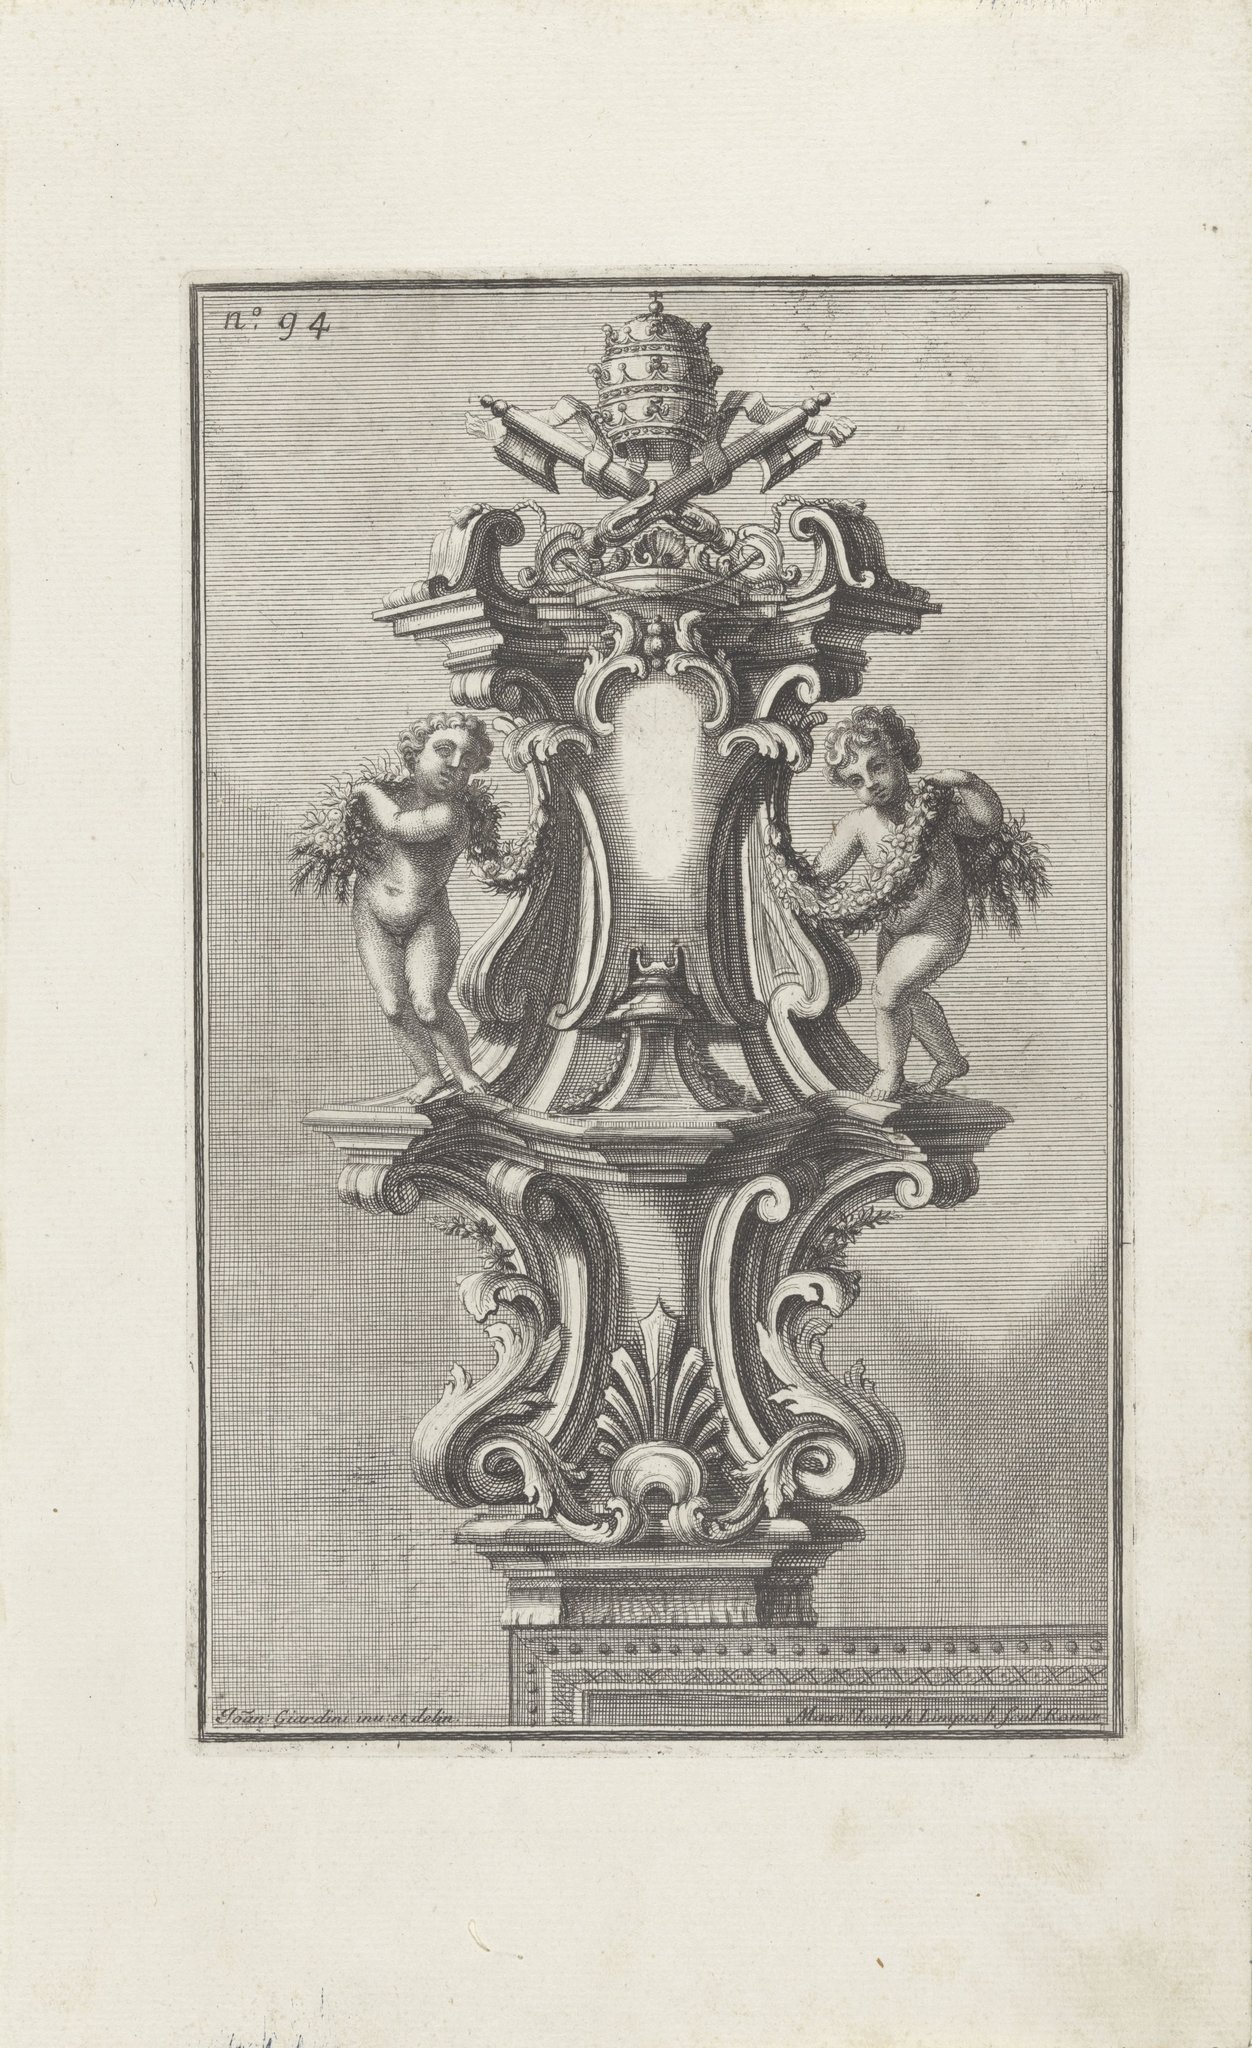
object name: print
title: Ornament met twee putti met guirlandes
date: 1714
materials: paper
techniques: etching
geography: rome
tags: coat of arms (symbol of sovereignty), ornaments ~ art, ornament ~ festoon, garland, cupids: 'amores', 'amoretti', 'putti'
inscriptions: collector's mark: Lugt 2228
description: Prent maakt deel uit van een reeks van 100 ornamentprenten naar ontwerp van Giovanni Giardini.